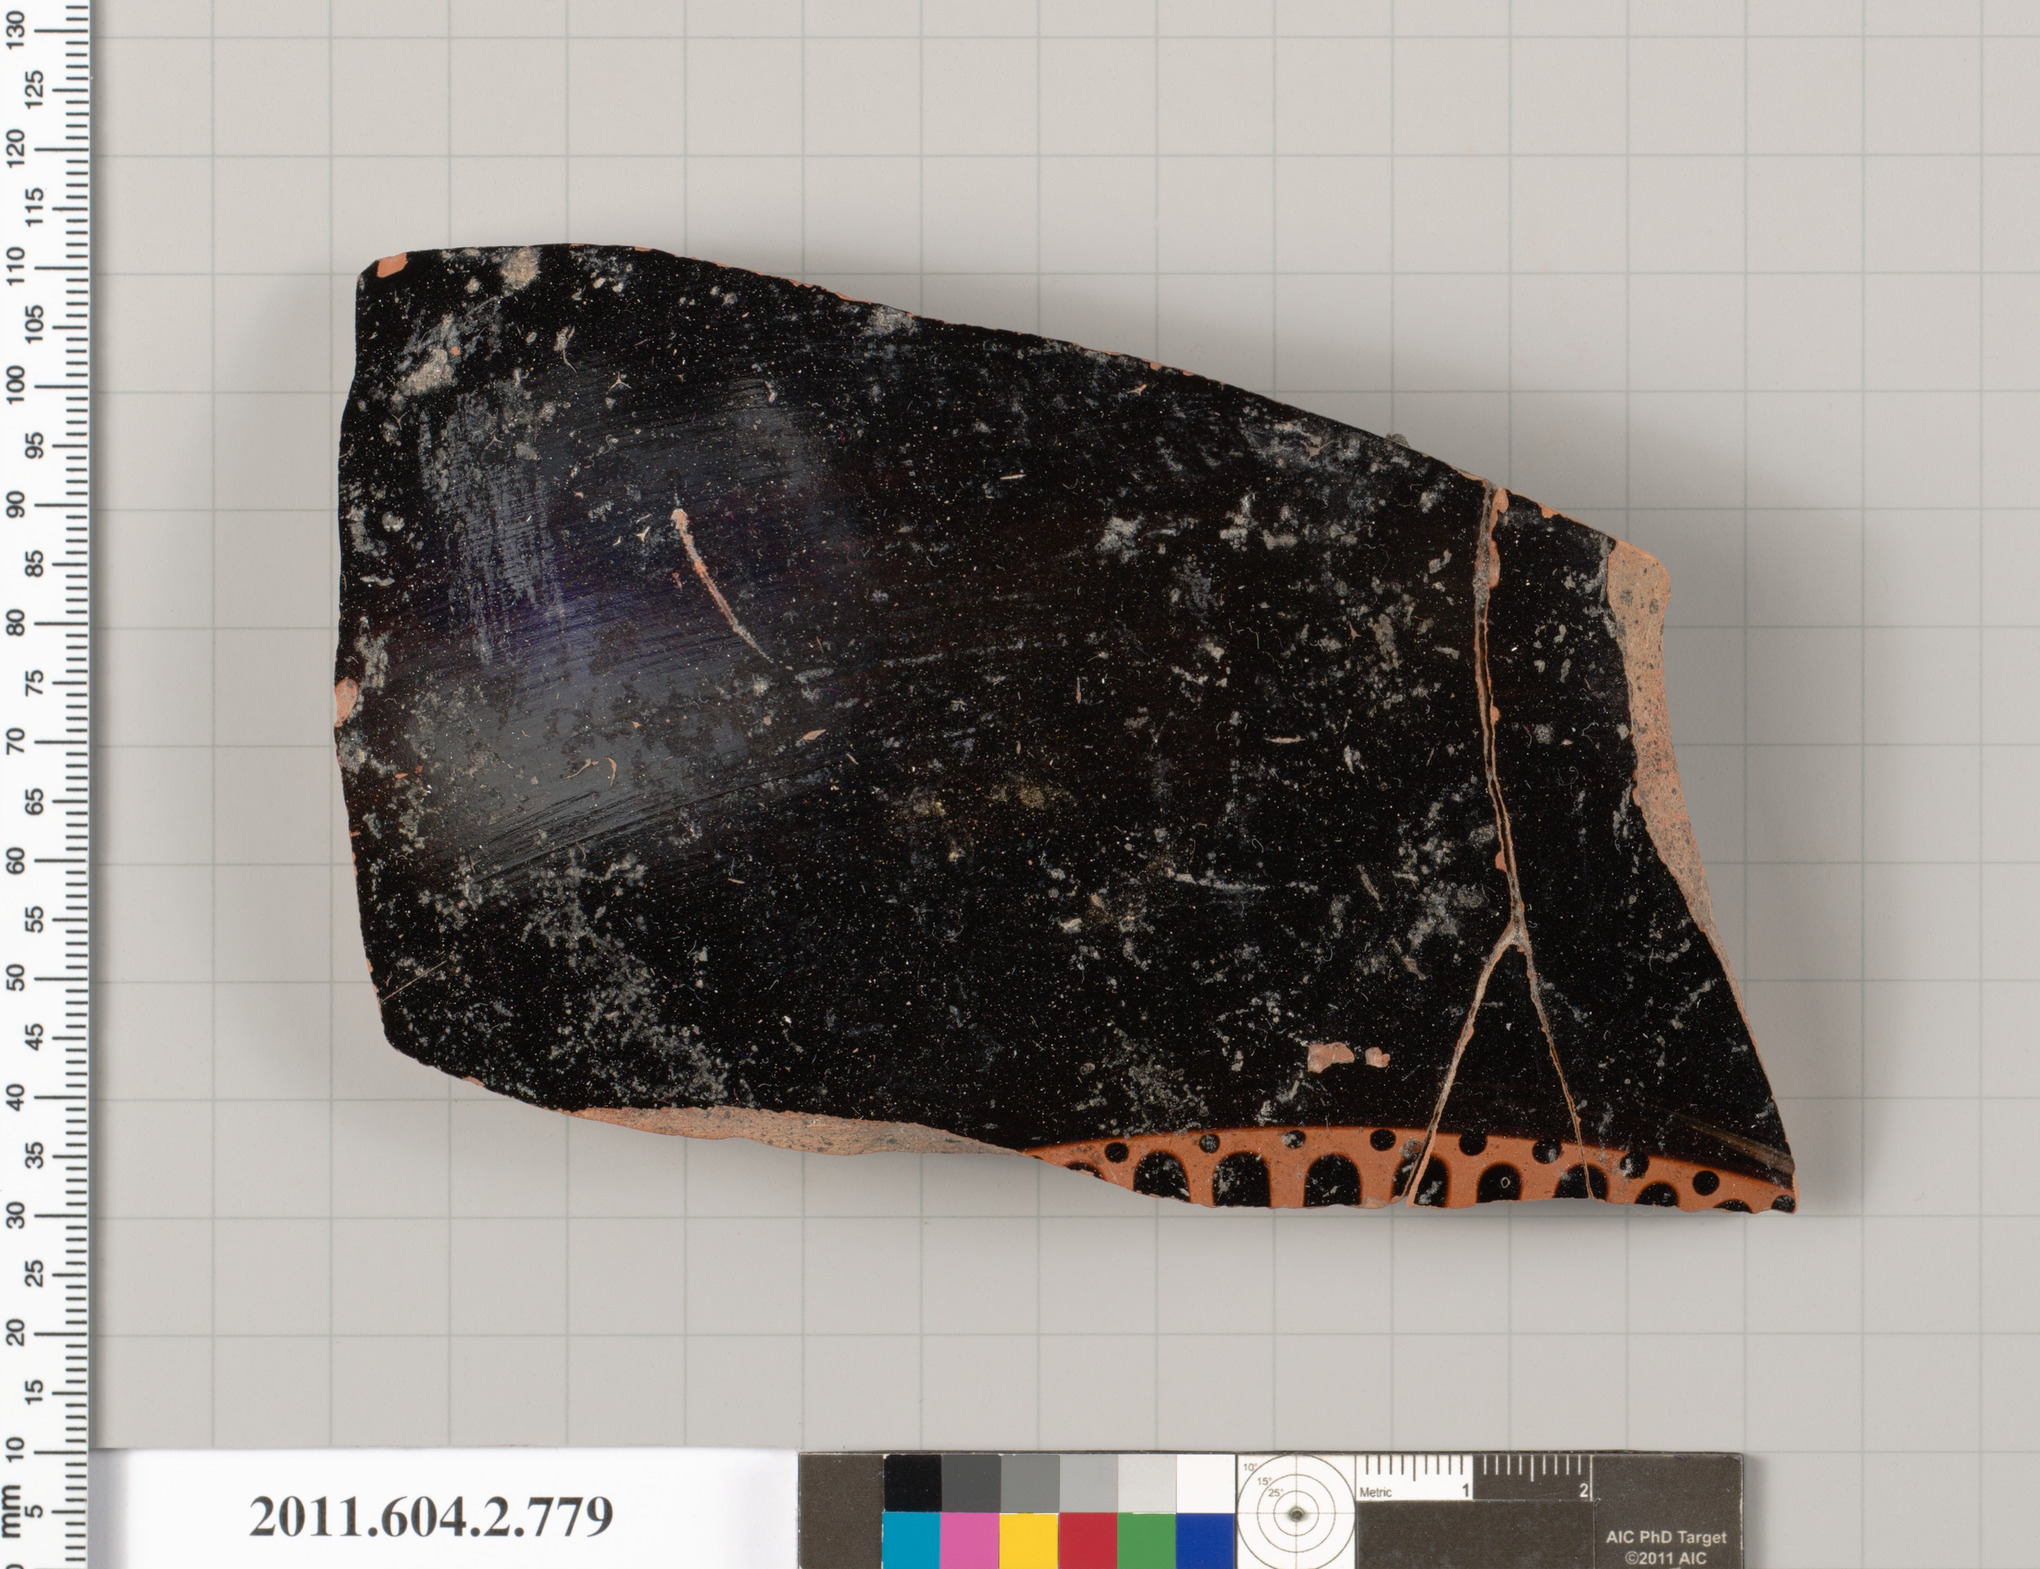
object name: calyx krater fragment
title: Terracotta fragment of a calyx-krater (bowl for mixing wine and water)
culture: greek, attic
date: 475-451 BCE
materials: terracotta